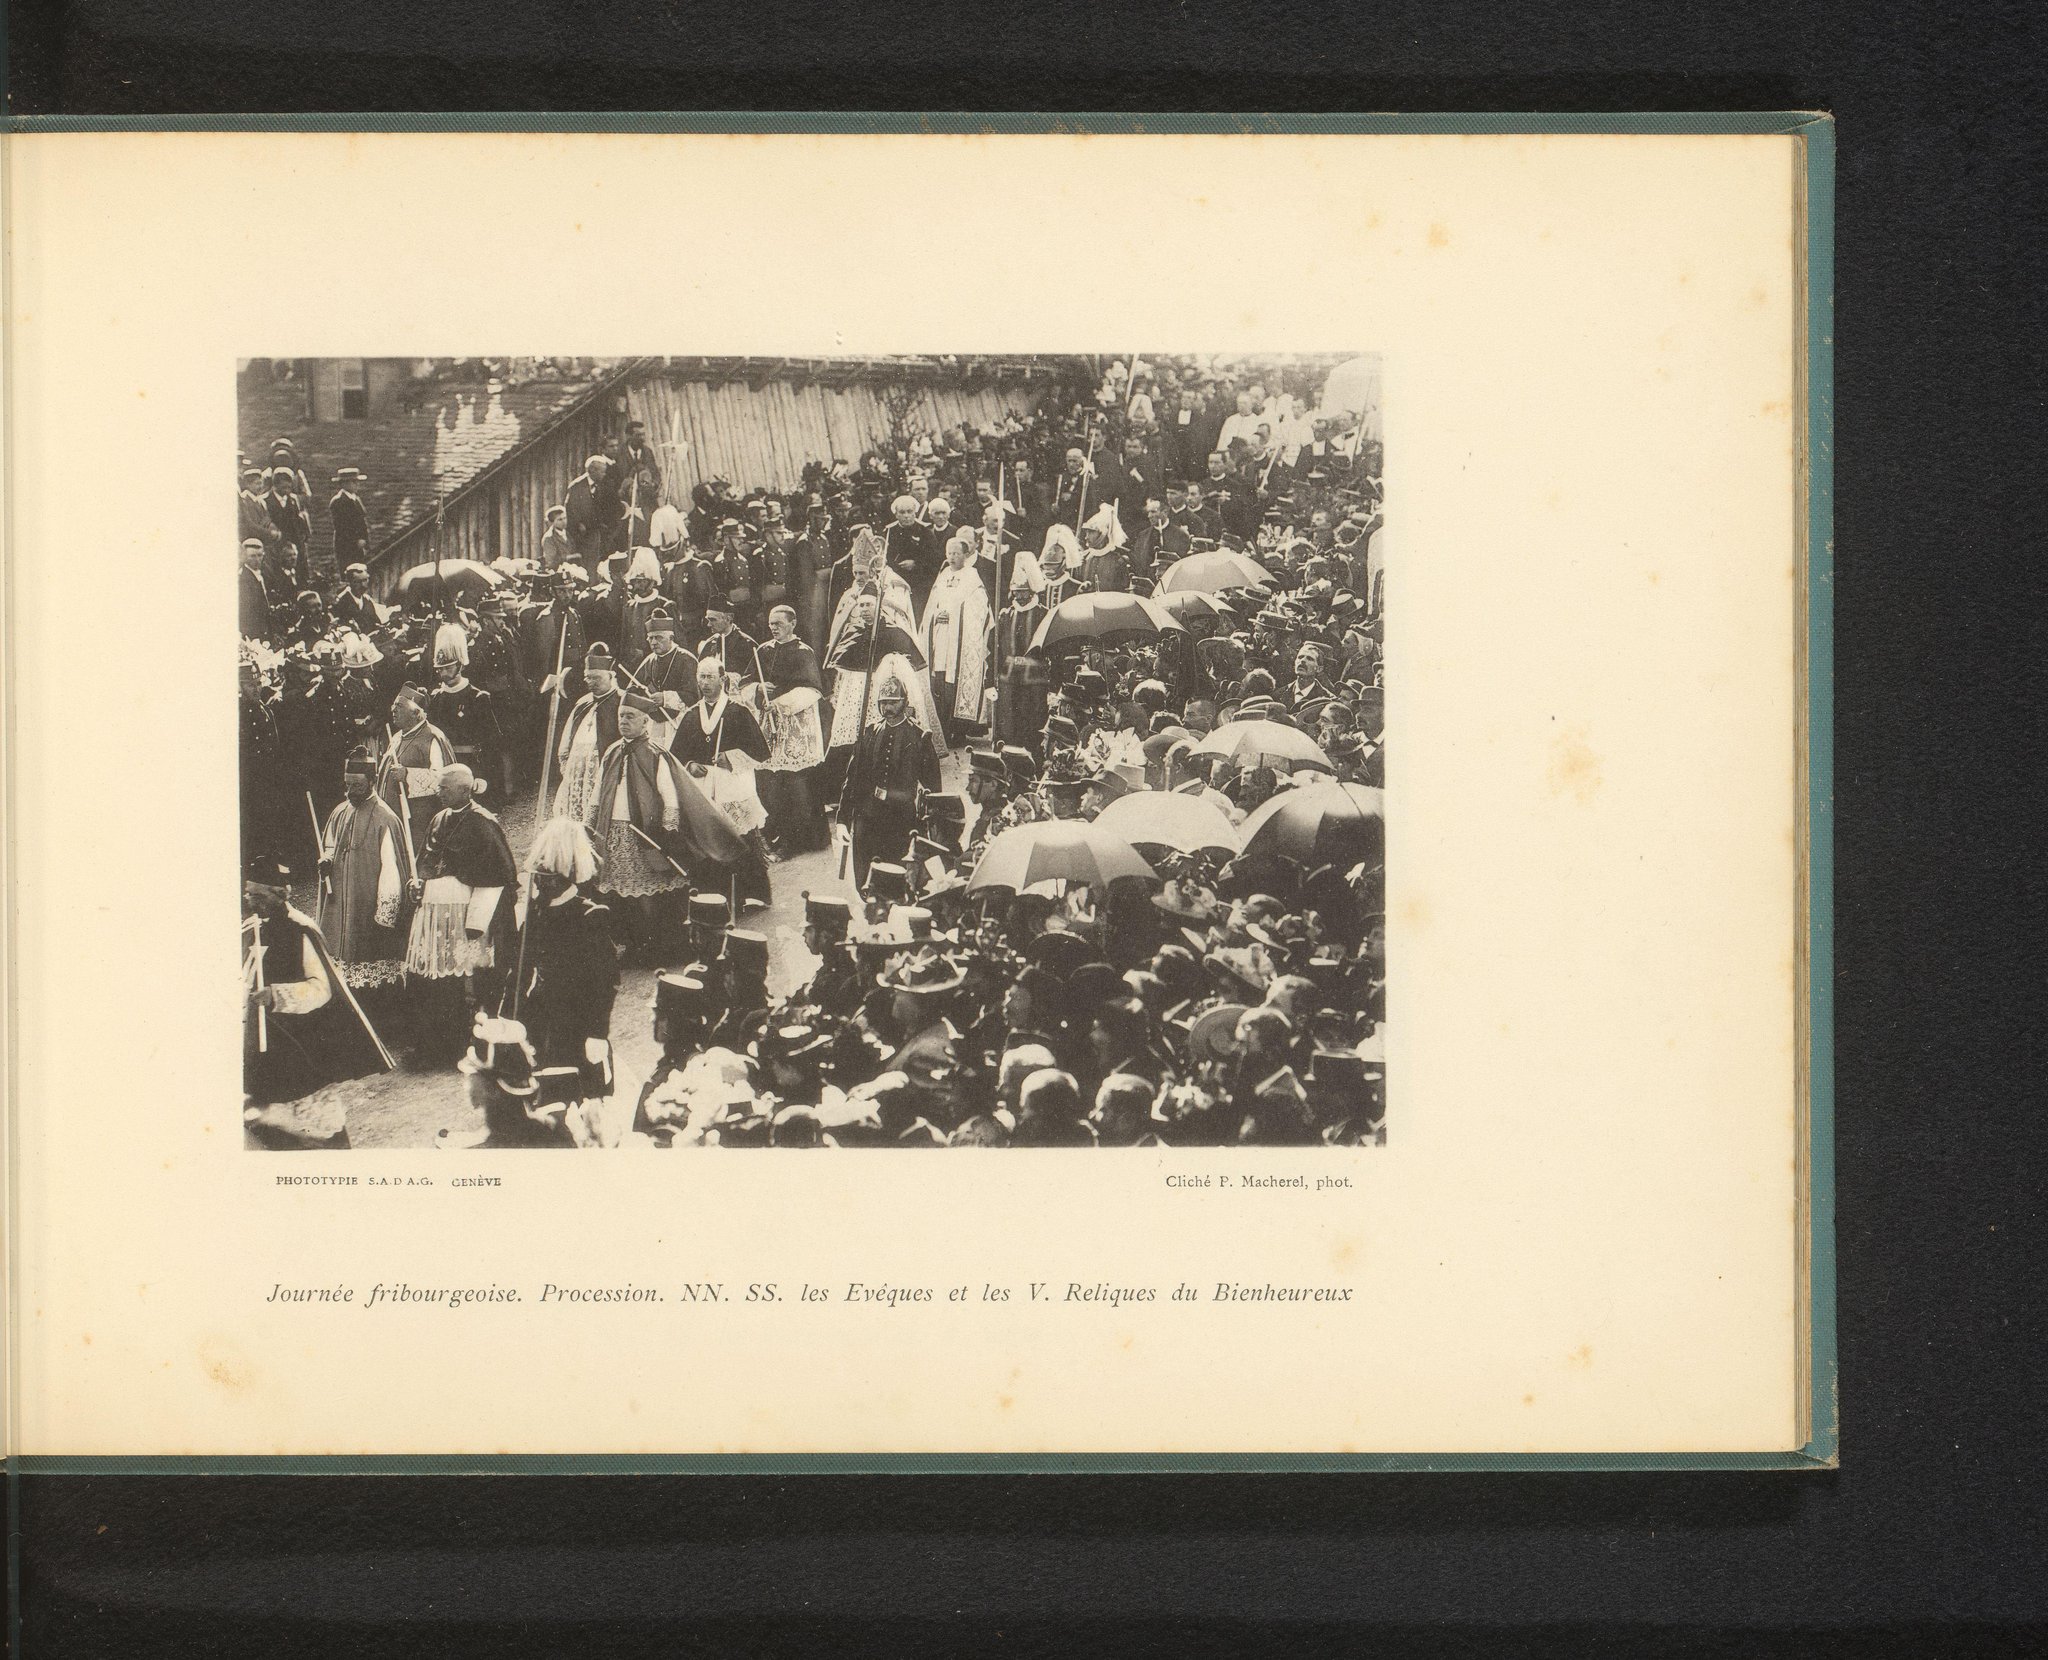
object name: page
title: Processie in Fribourg, vermoedelijk ter herdenking van de sterfdag van Petrus Canisius in 1597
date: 1897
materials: paper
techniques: photograph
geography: geneva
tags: public festivities, procession ~ christian religion